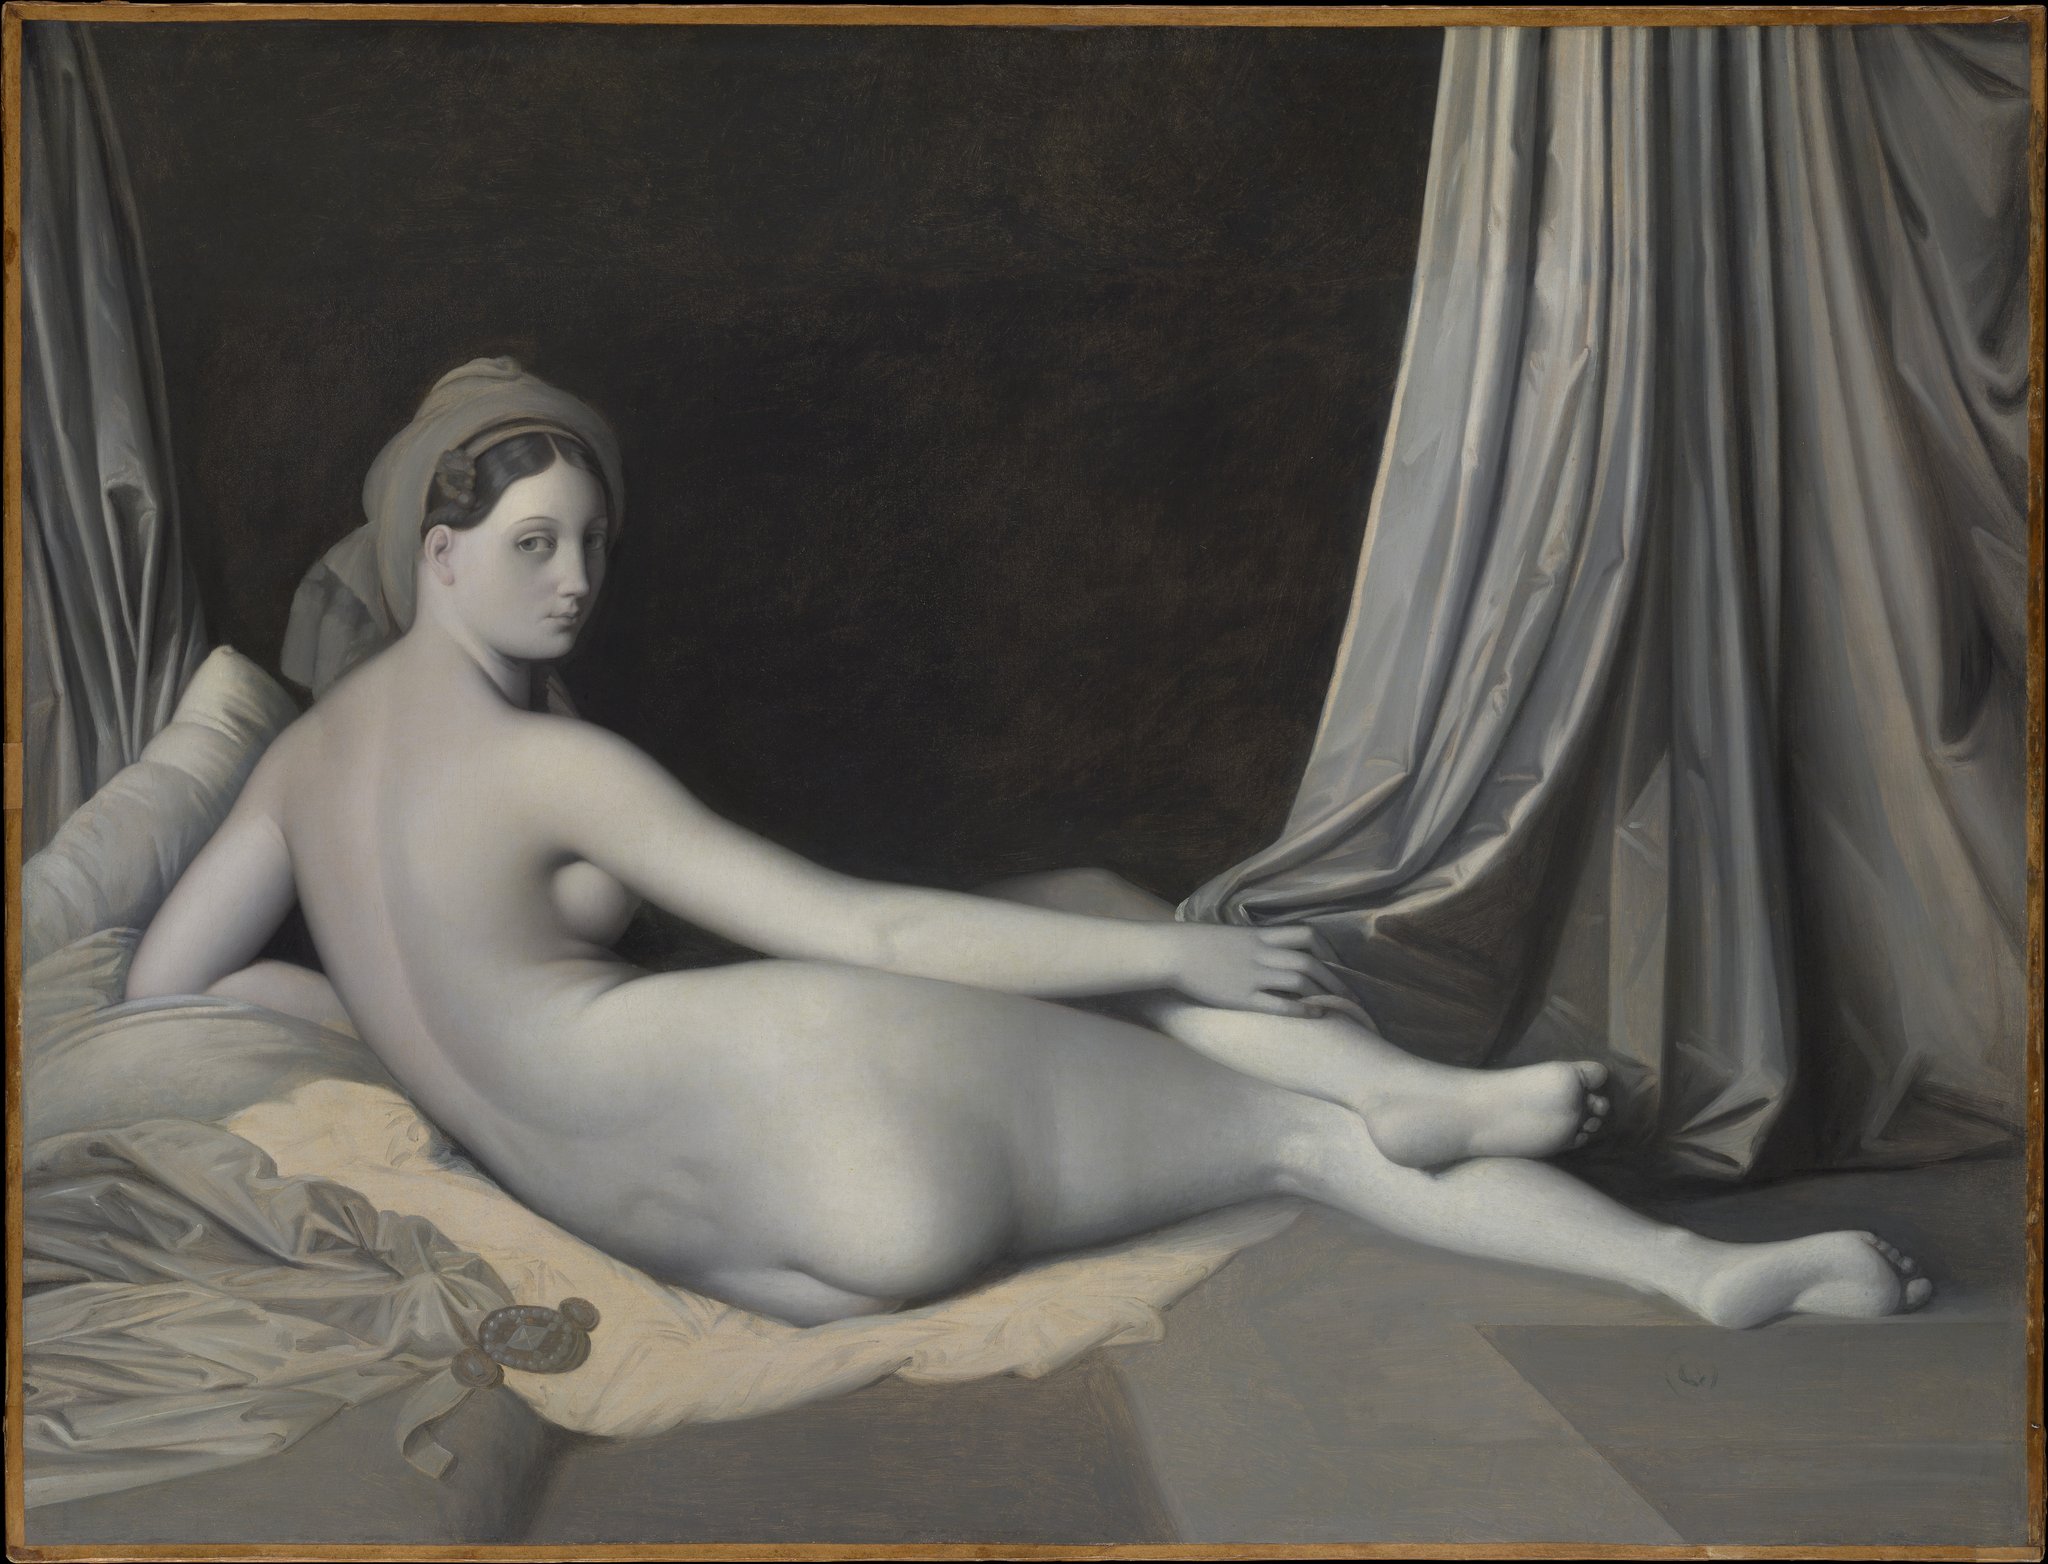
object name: painting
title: Odalisque in Grisaille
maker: jean auguste dominique ingres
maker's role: artist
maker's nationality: french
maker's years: 1780-1867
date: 1824-1834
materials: canvas, oil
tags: female nudes,orientalist